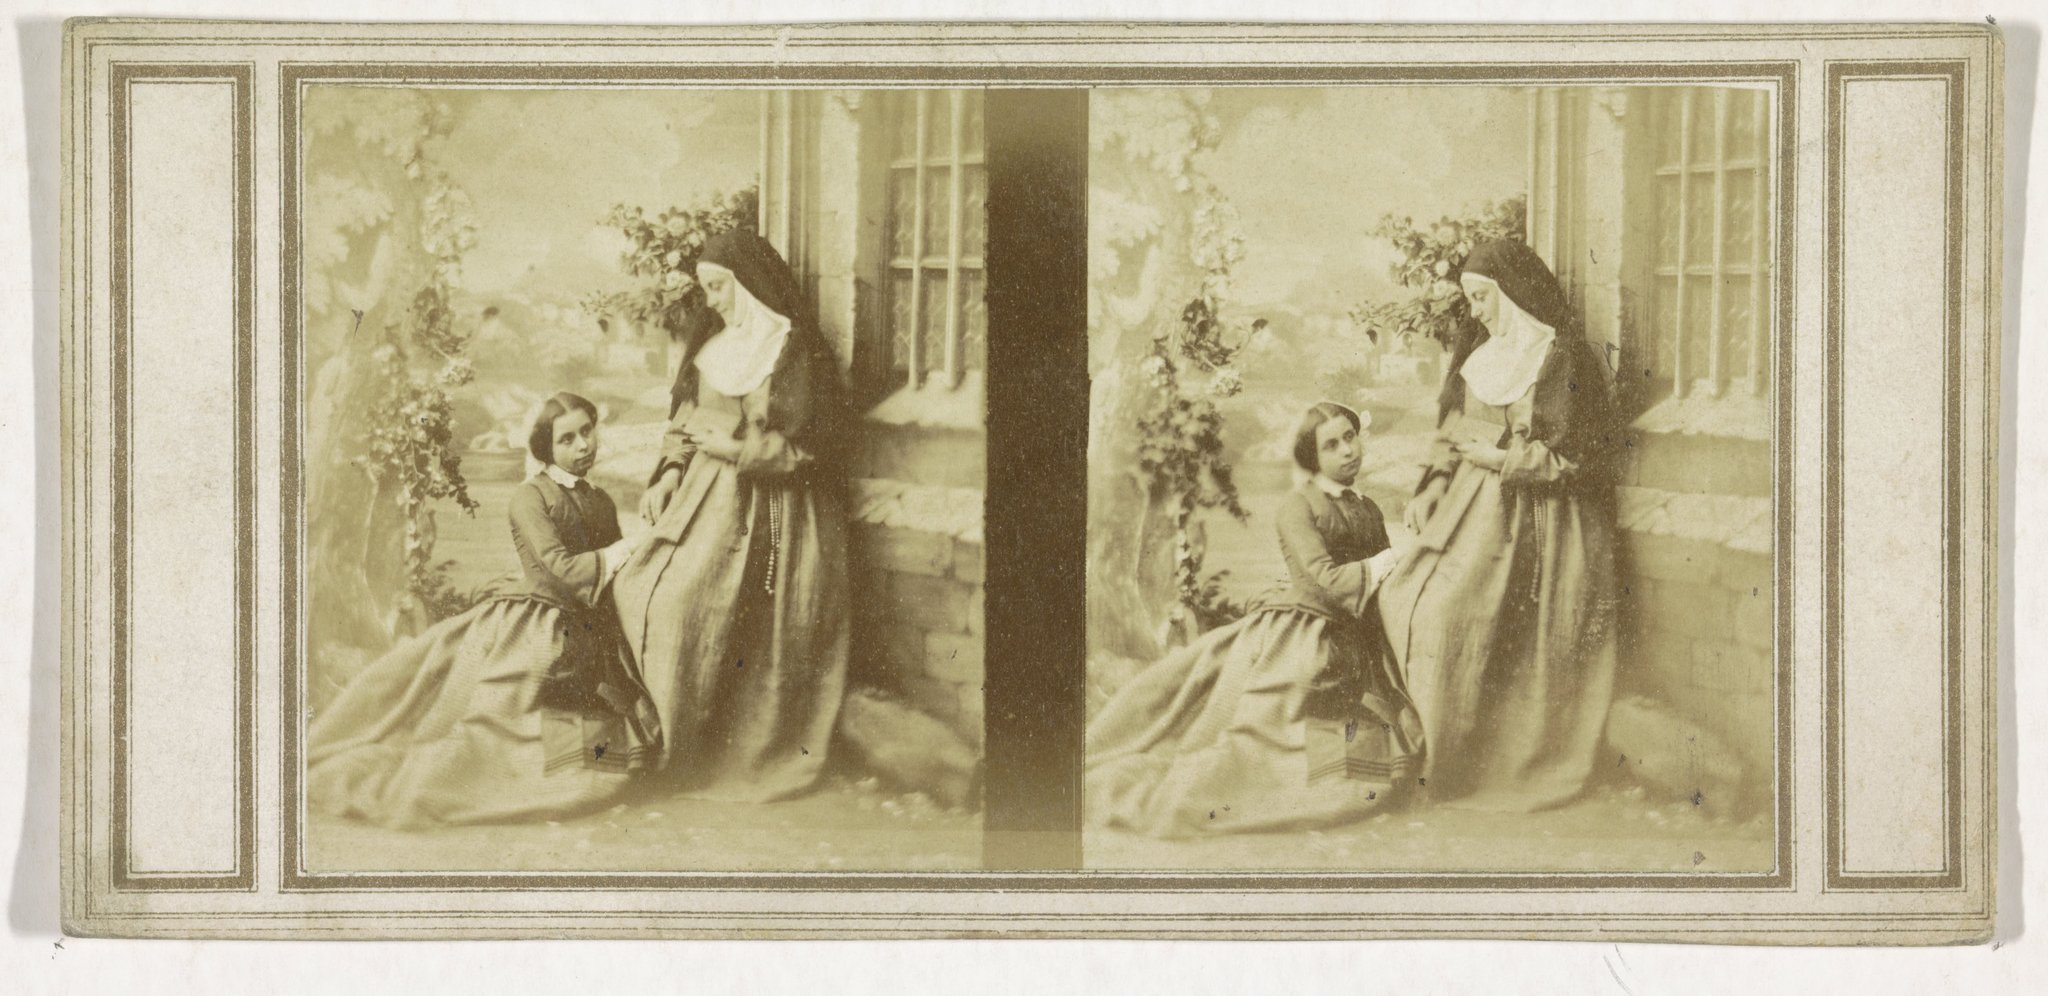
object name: stereograph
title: Meisje knielend naast non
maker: pierre-ambroise richebourg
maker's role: fotograaf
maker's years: 1810-1875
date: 1850-1870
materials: photographic support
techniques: albumen print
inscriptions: annotation: ‘46300n (?)’, number: ‘47’